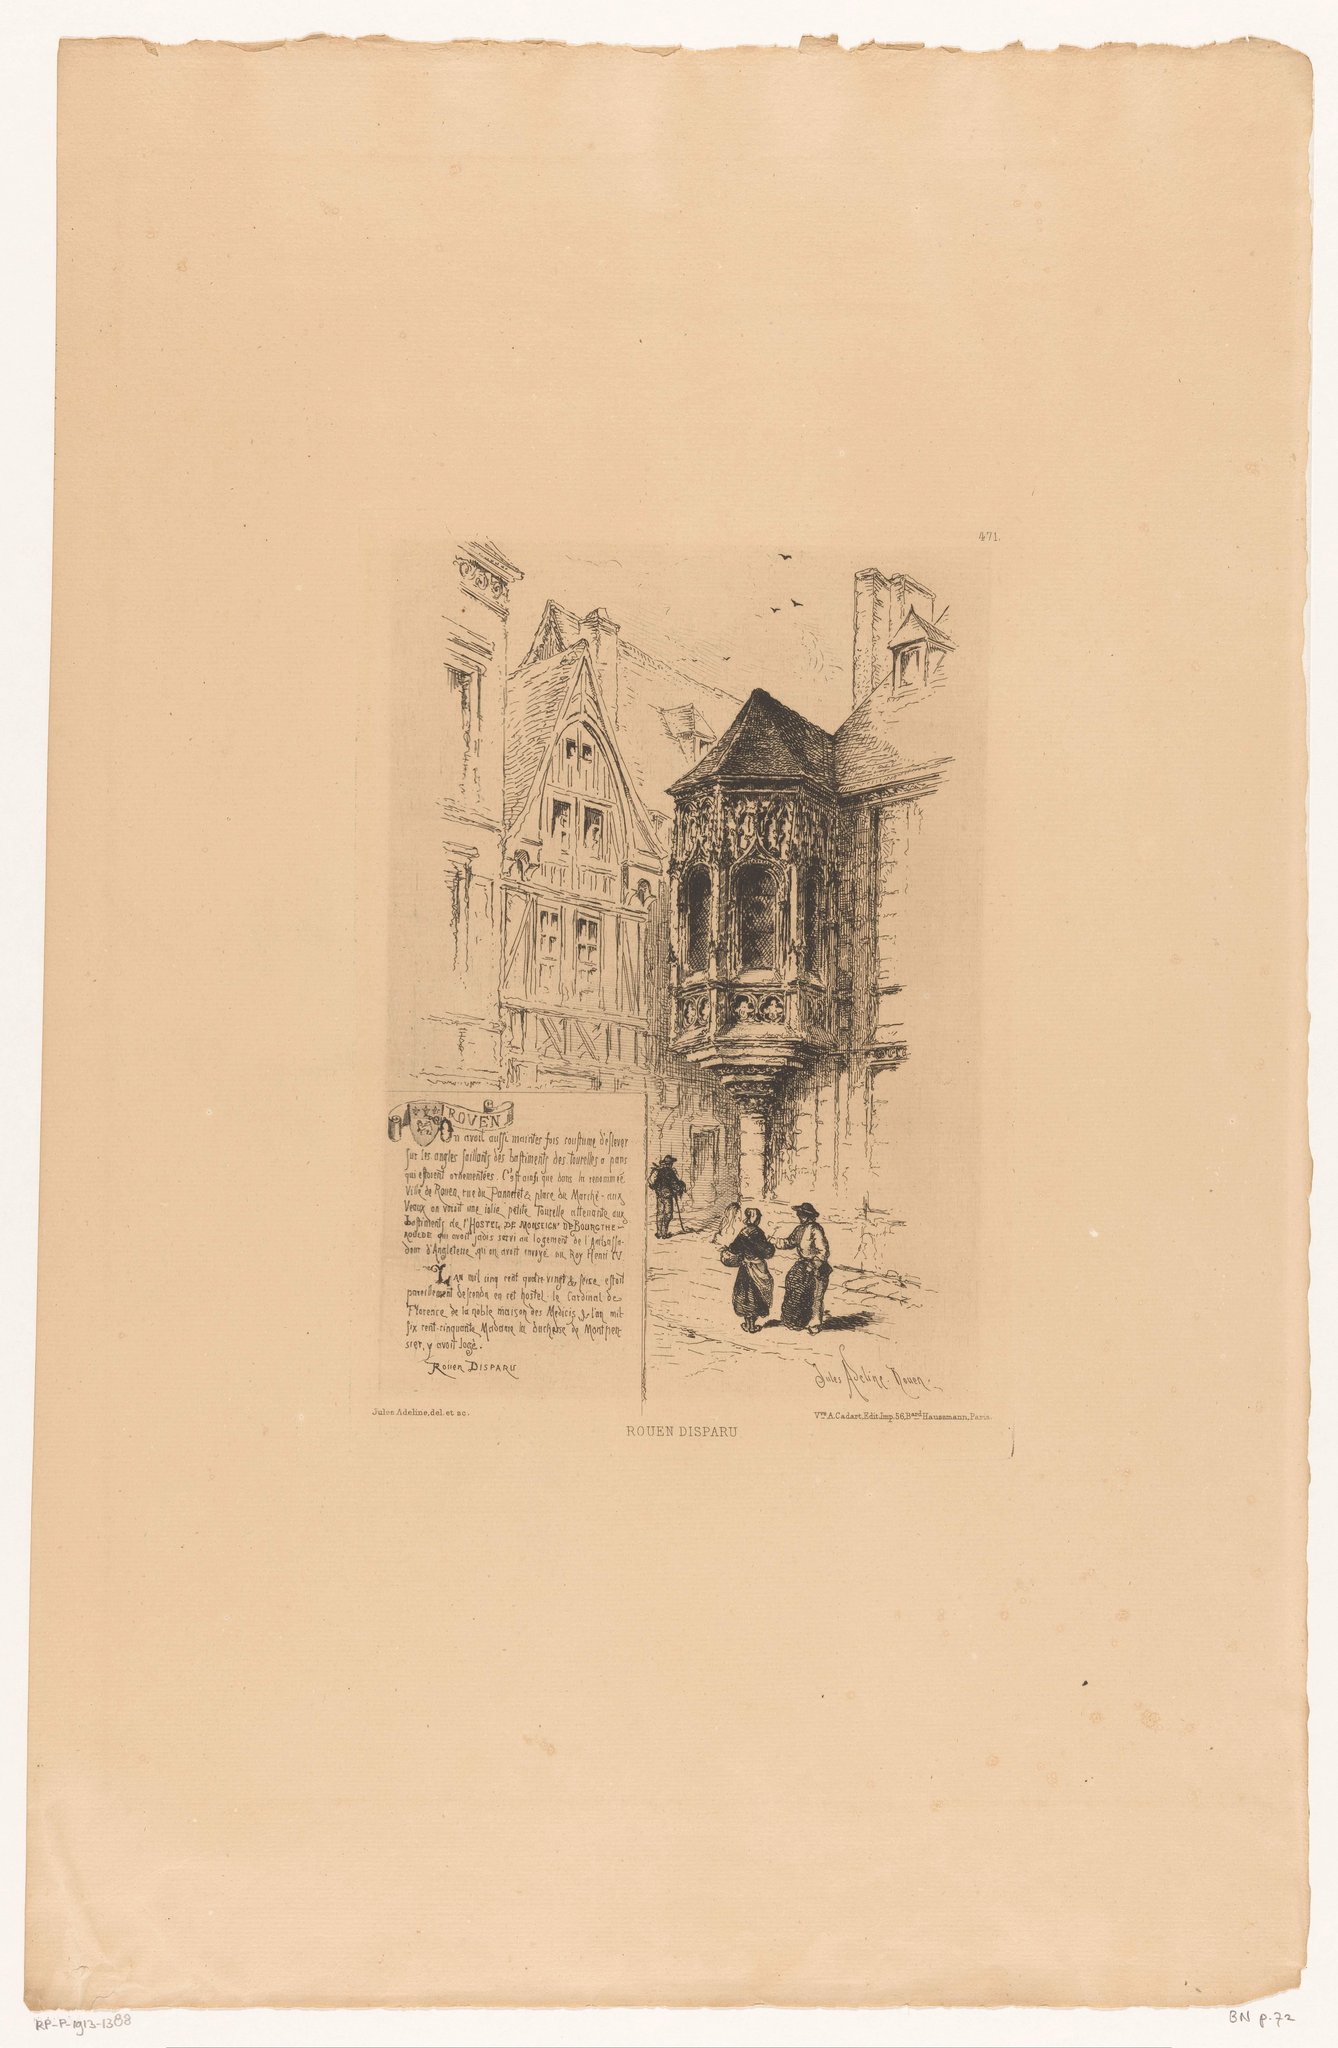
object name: print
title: Het verdwenen Rouen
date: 1875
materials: paper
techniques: etching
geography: paris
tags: urban housing, standing figure - aa - female human figure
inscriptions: collector's mark: Lugt 2233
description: De ets werd ook gebruikt als illustratie in het tijdschrift "L'illustration nouvelle", uitgegeven door Cadart in Parijs.